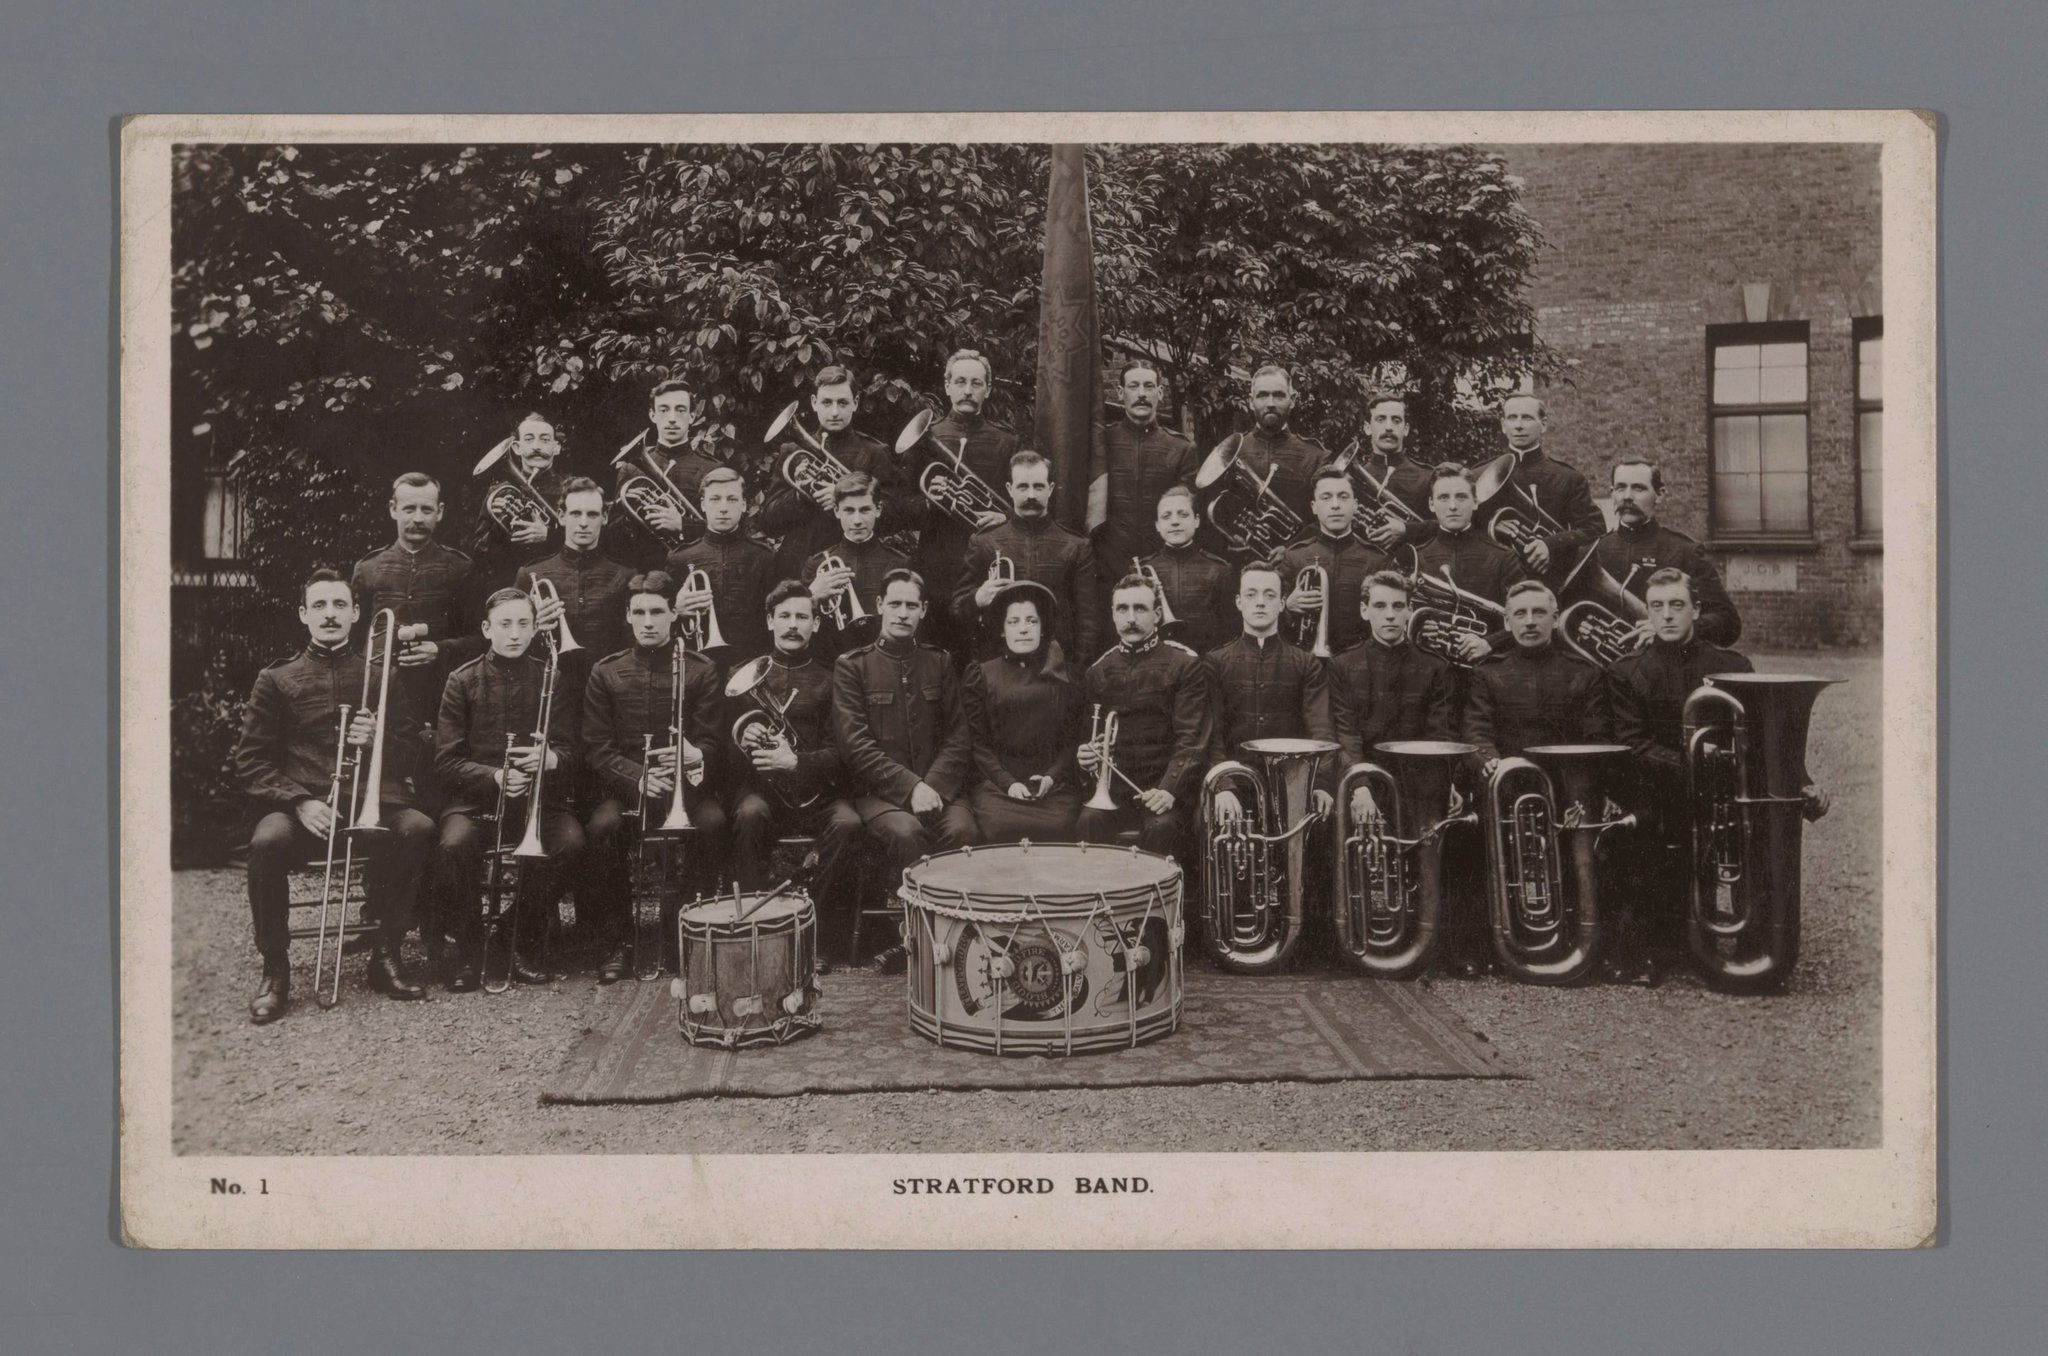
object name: photograph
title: Groepsportret van een muziekensemble van het Leger des Heils te Stratford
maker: Anonymous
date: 1907-1920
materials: photographic support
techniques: gelatin silver print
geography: london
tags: functionaries and dignitaries in the salvation army, brass band, street band - cc - out of doors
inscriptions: number: ‘No. 1’